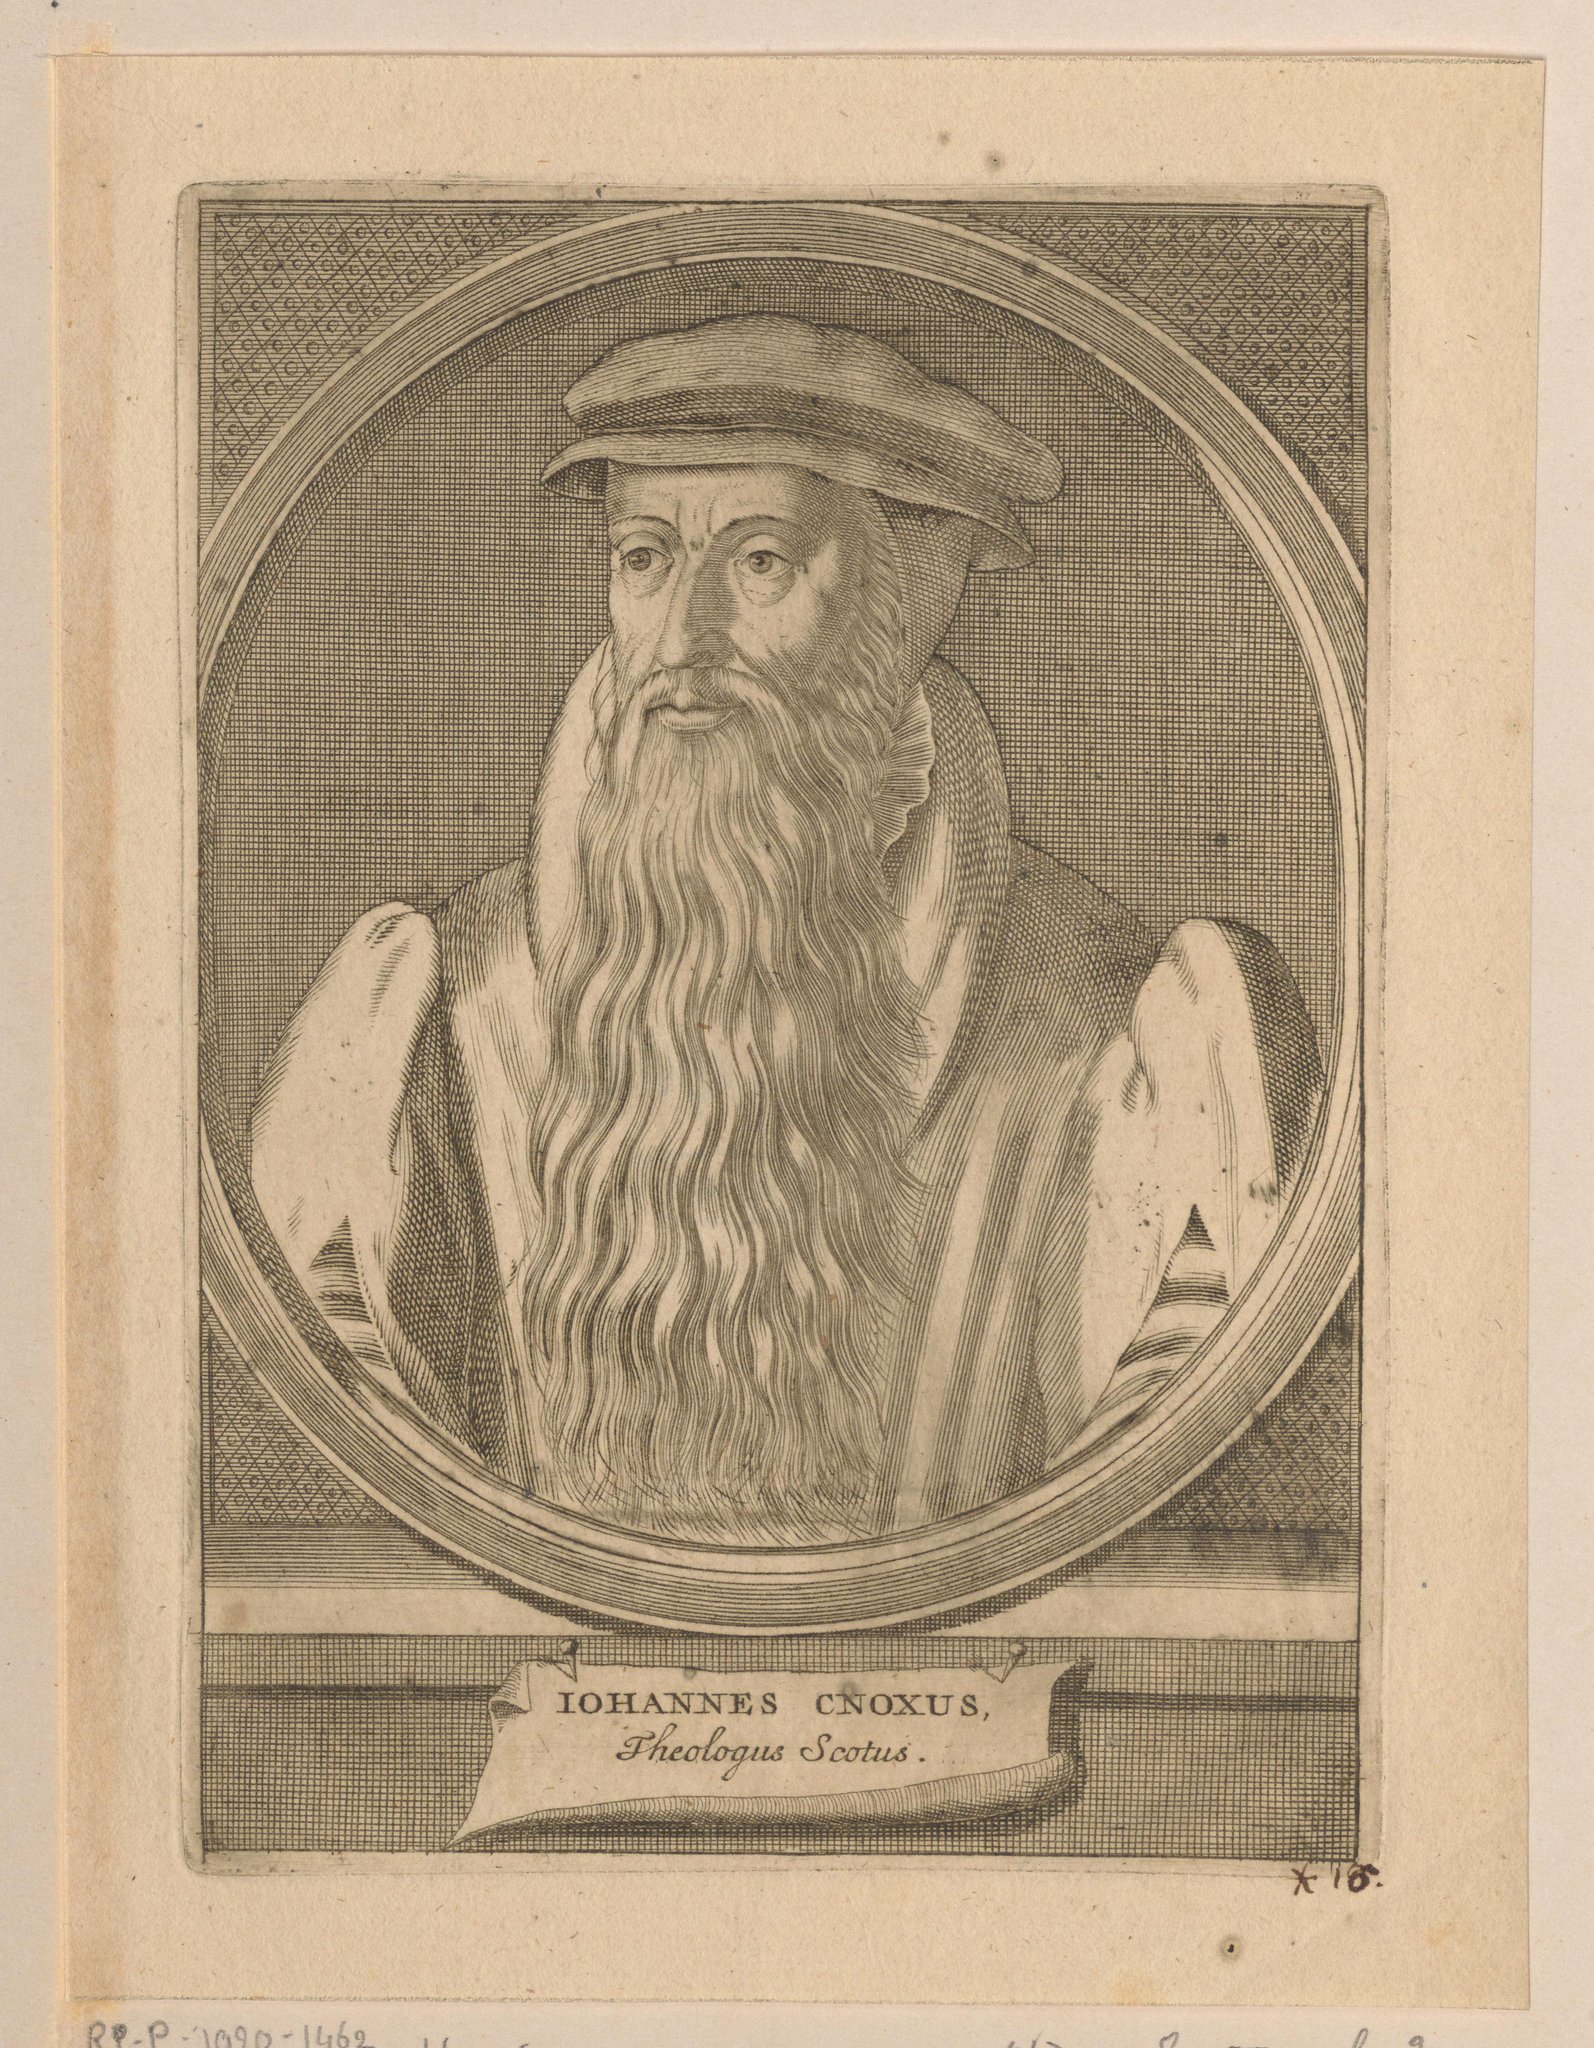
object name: print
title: Protestantse hervormers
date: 1690-1729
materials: paper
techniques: engraving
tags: historical persons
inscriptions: collector's mark: Lugt 2228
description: Prent mogelijk uit: Le miroir des portraits des premiers reformateurs des églises protestantes. Leiden: Pieter van der Aa, [1690-1729]. Eerdere staat gebruikt in serie uit 1599 en publicaties uit 1602 en 1604.